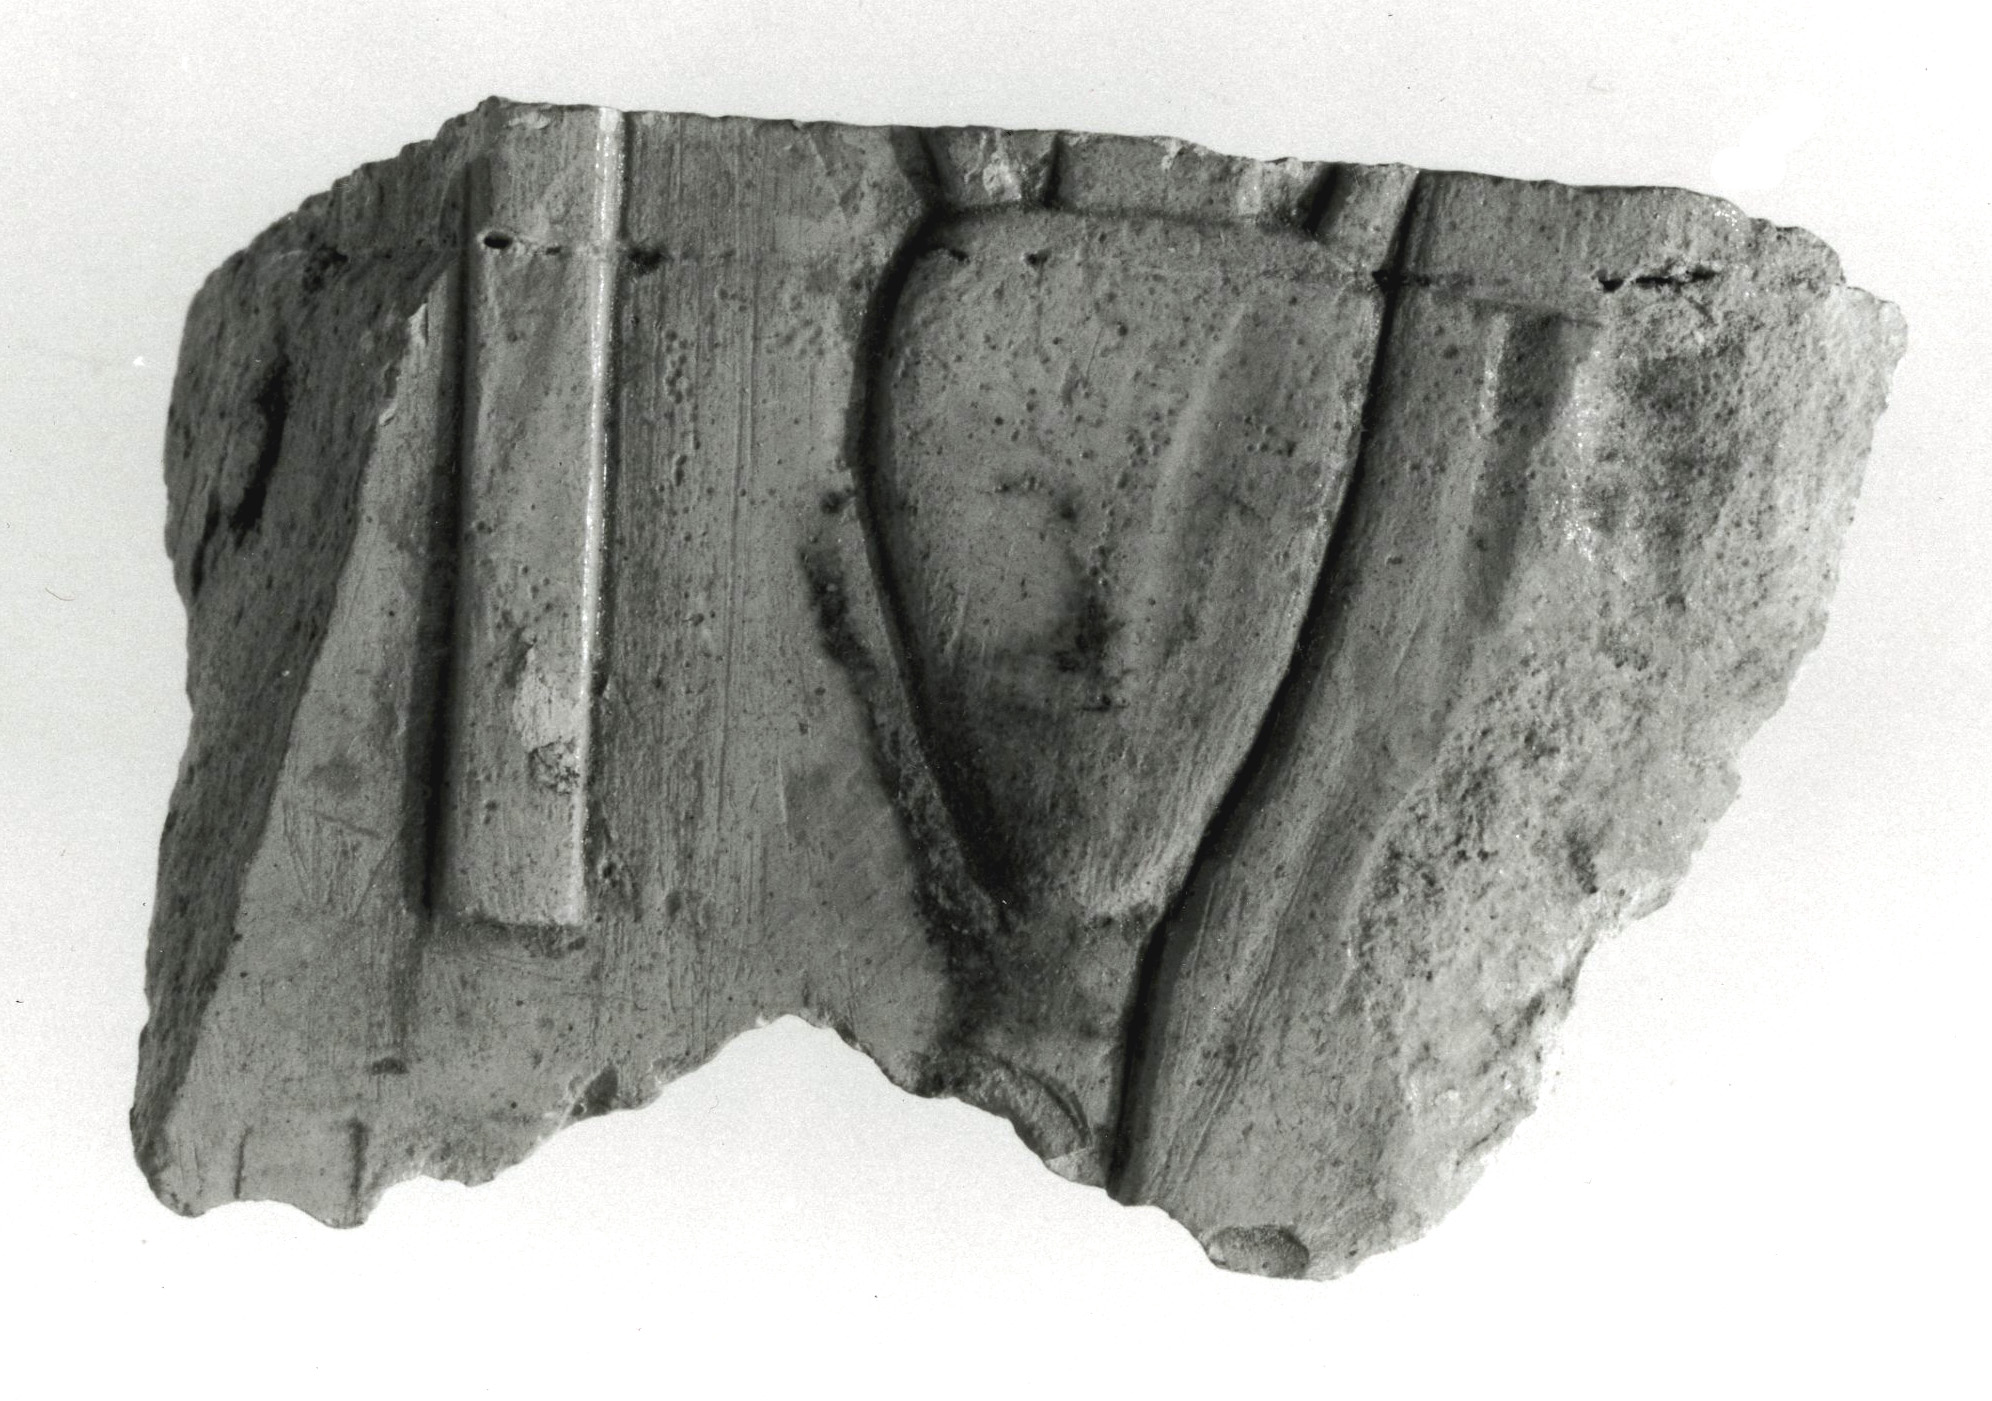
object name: relief, tomb of nespekashuty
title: Raised Relief Fragment with Fragmentary Hieroglyphs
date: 664-610 BCE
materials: limestone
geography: egypt